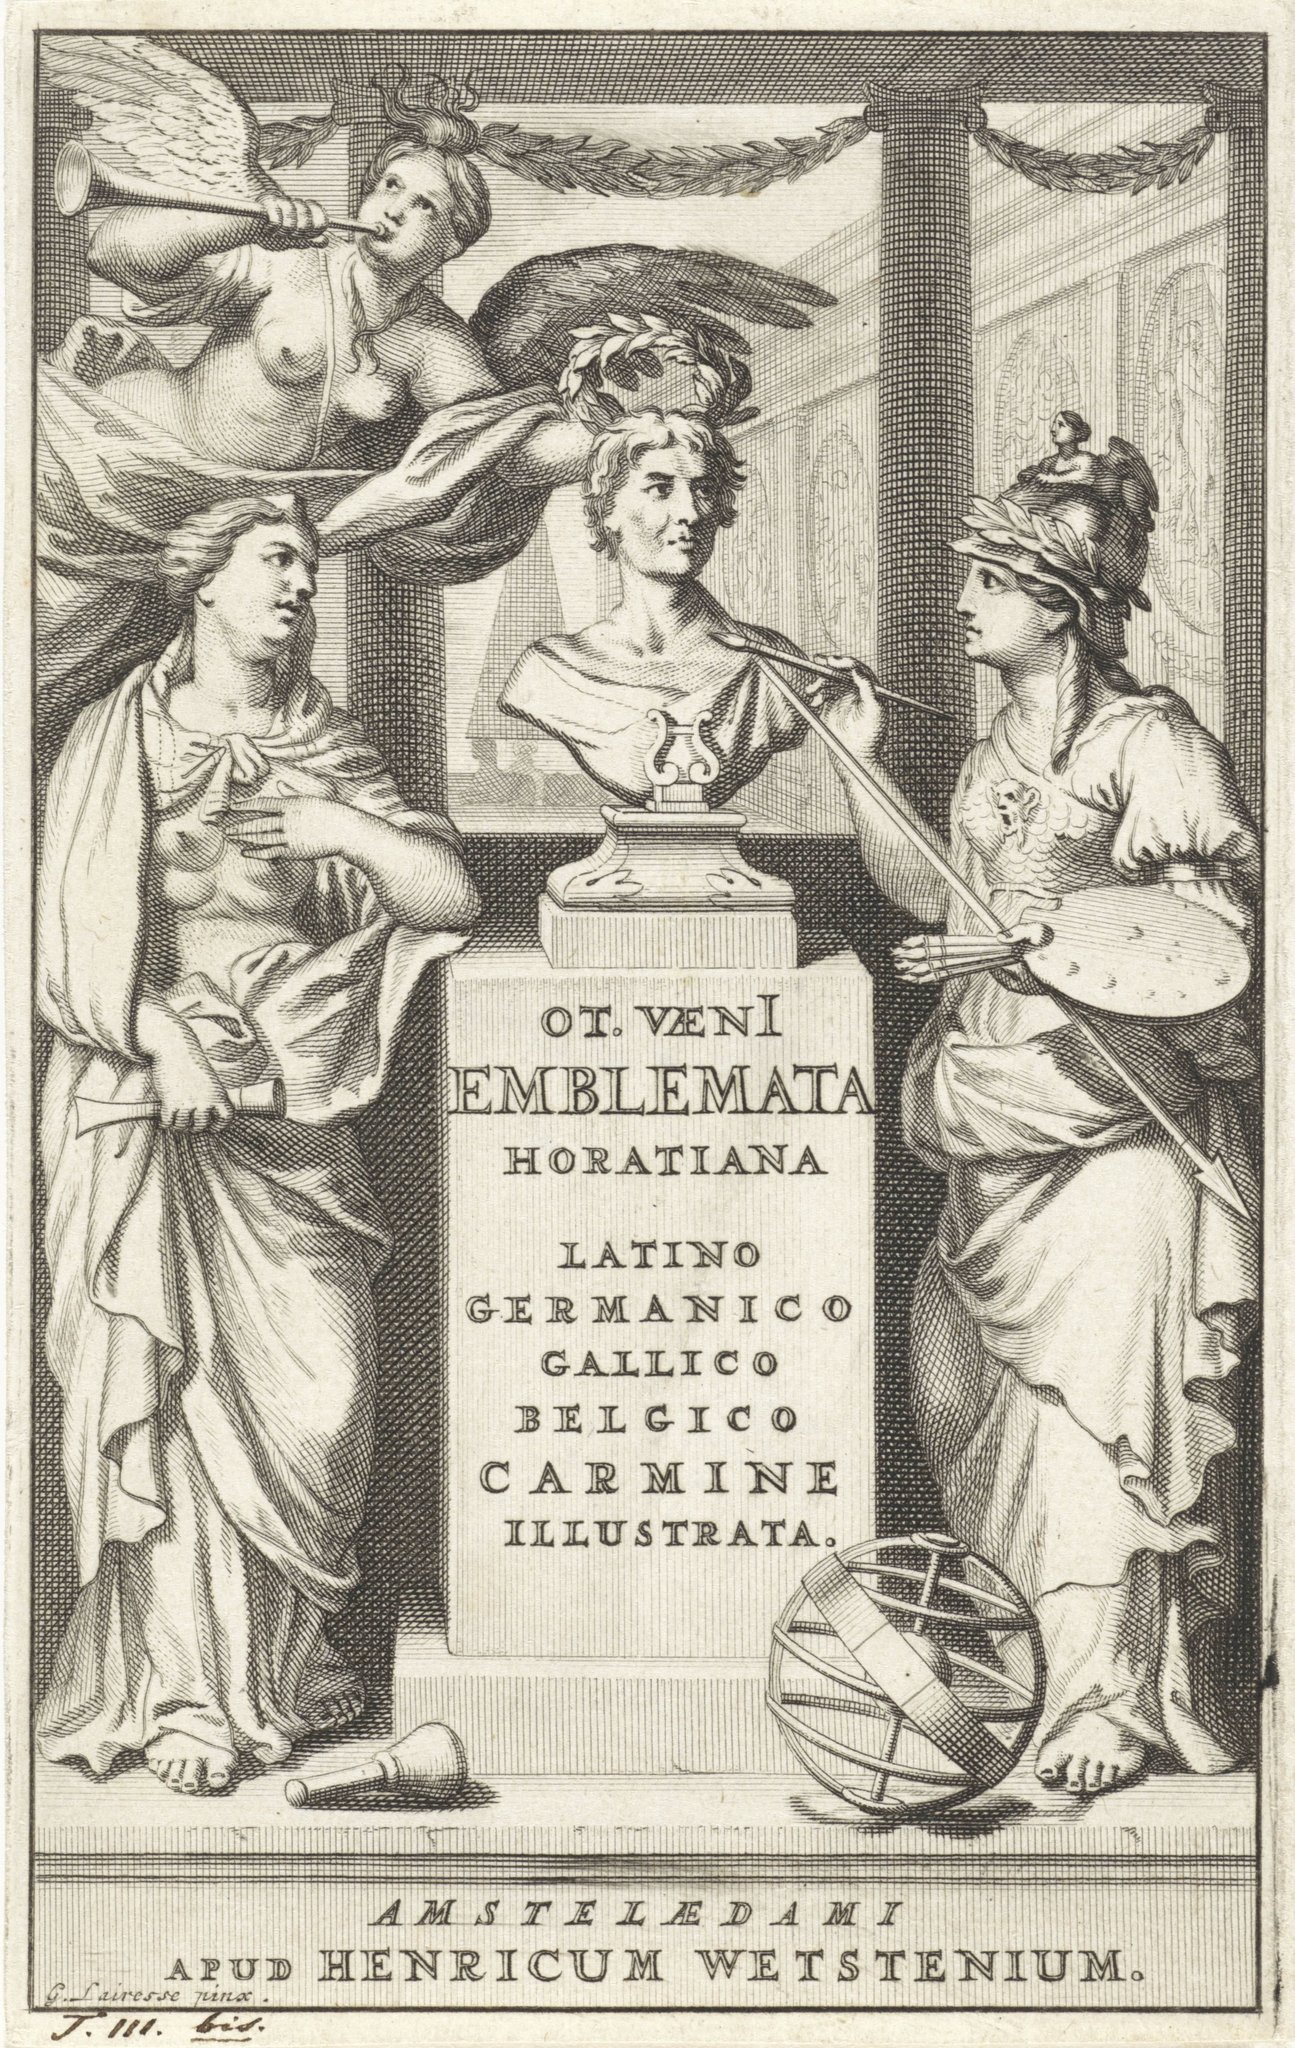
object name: titelblad, titelpagina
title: Allegorie op Horatius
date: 1684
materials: paper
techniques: engraving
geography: low countries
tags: abstract ideas and concepts (+ allegorical scene, i.e. two or more personifications involved in an action), fama as roman personification, tools, implements of painter, sculpture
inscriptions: inscription: ‘T. III. bis’, collector's mark: Lugt 11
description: In het midden een portretbuste van de Romeinse dichter Horatius op een sokkel. De sculptuur wordt met een lauwerkrans gekroond door Faam, die op haar bazuin blaast. Rechts een allegorische figuur met schildersbenodigdheden in haar handen. Haar hoofddeksel is versierd met een lauwerkrans en een sfinx als symbool van wijsheid. Links een allegorische figuur met een instrument in haar hand.